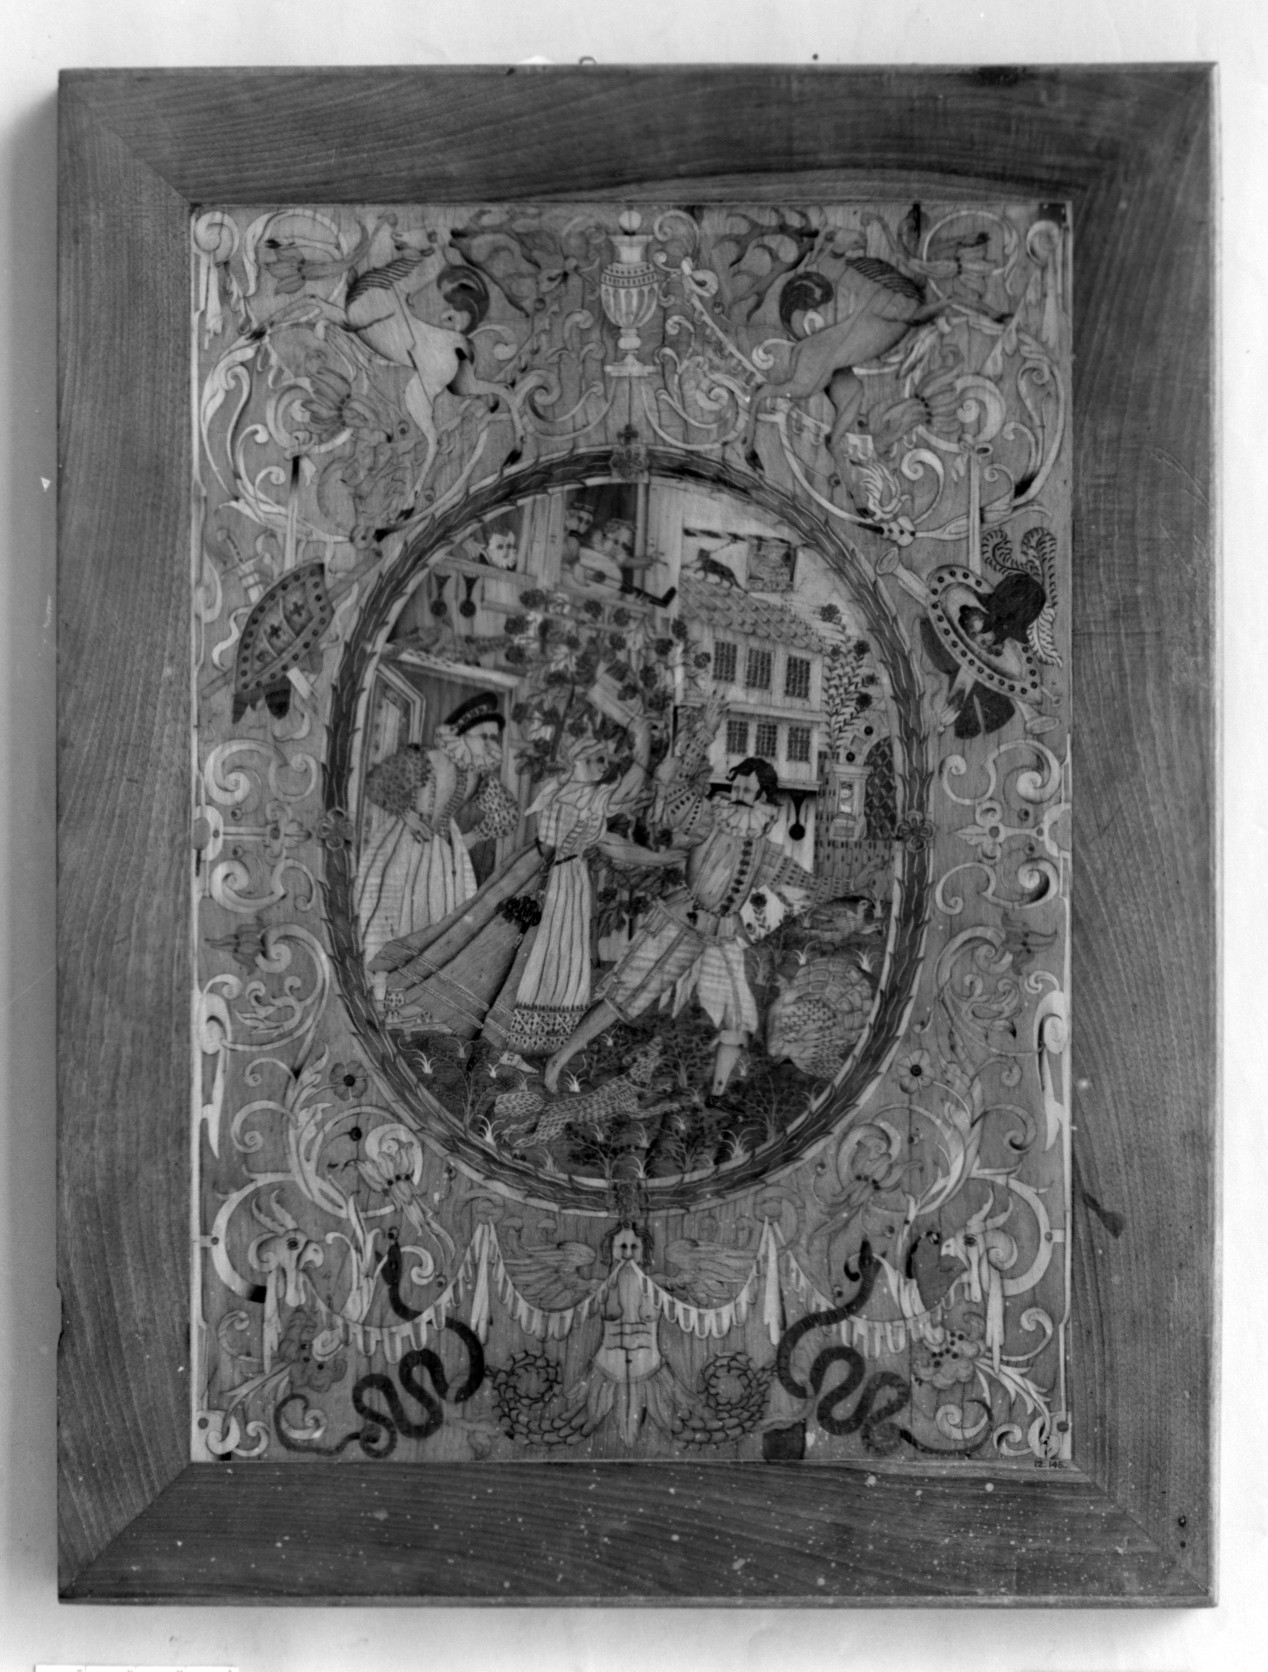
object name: panel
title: Intarsia panel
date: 1567-1600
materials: wood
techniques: stain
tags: men,women